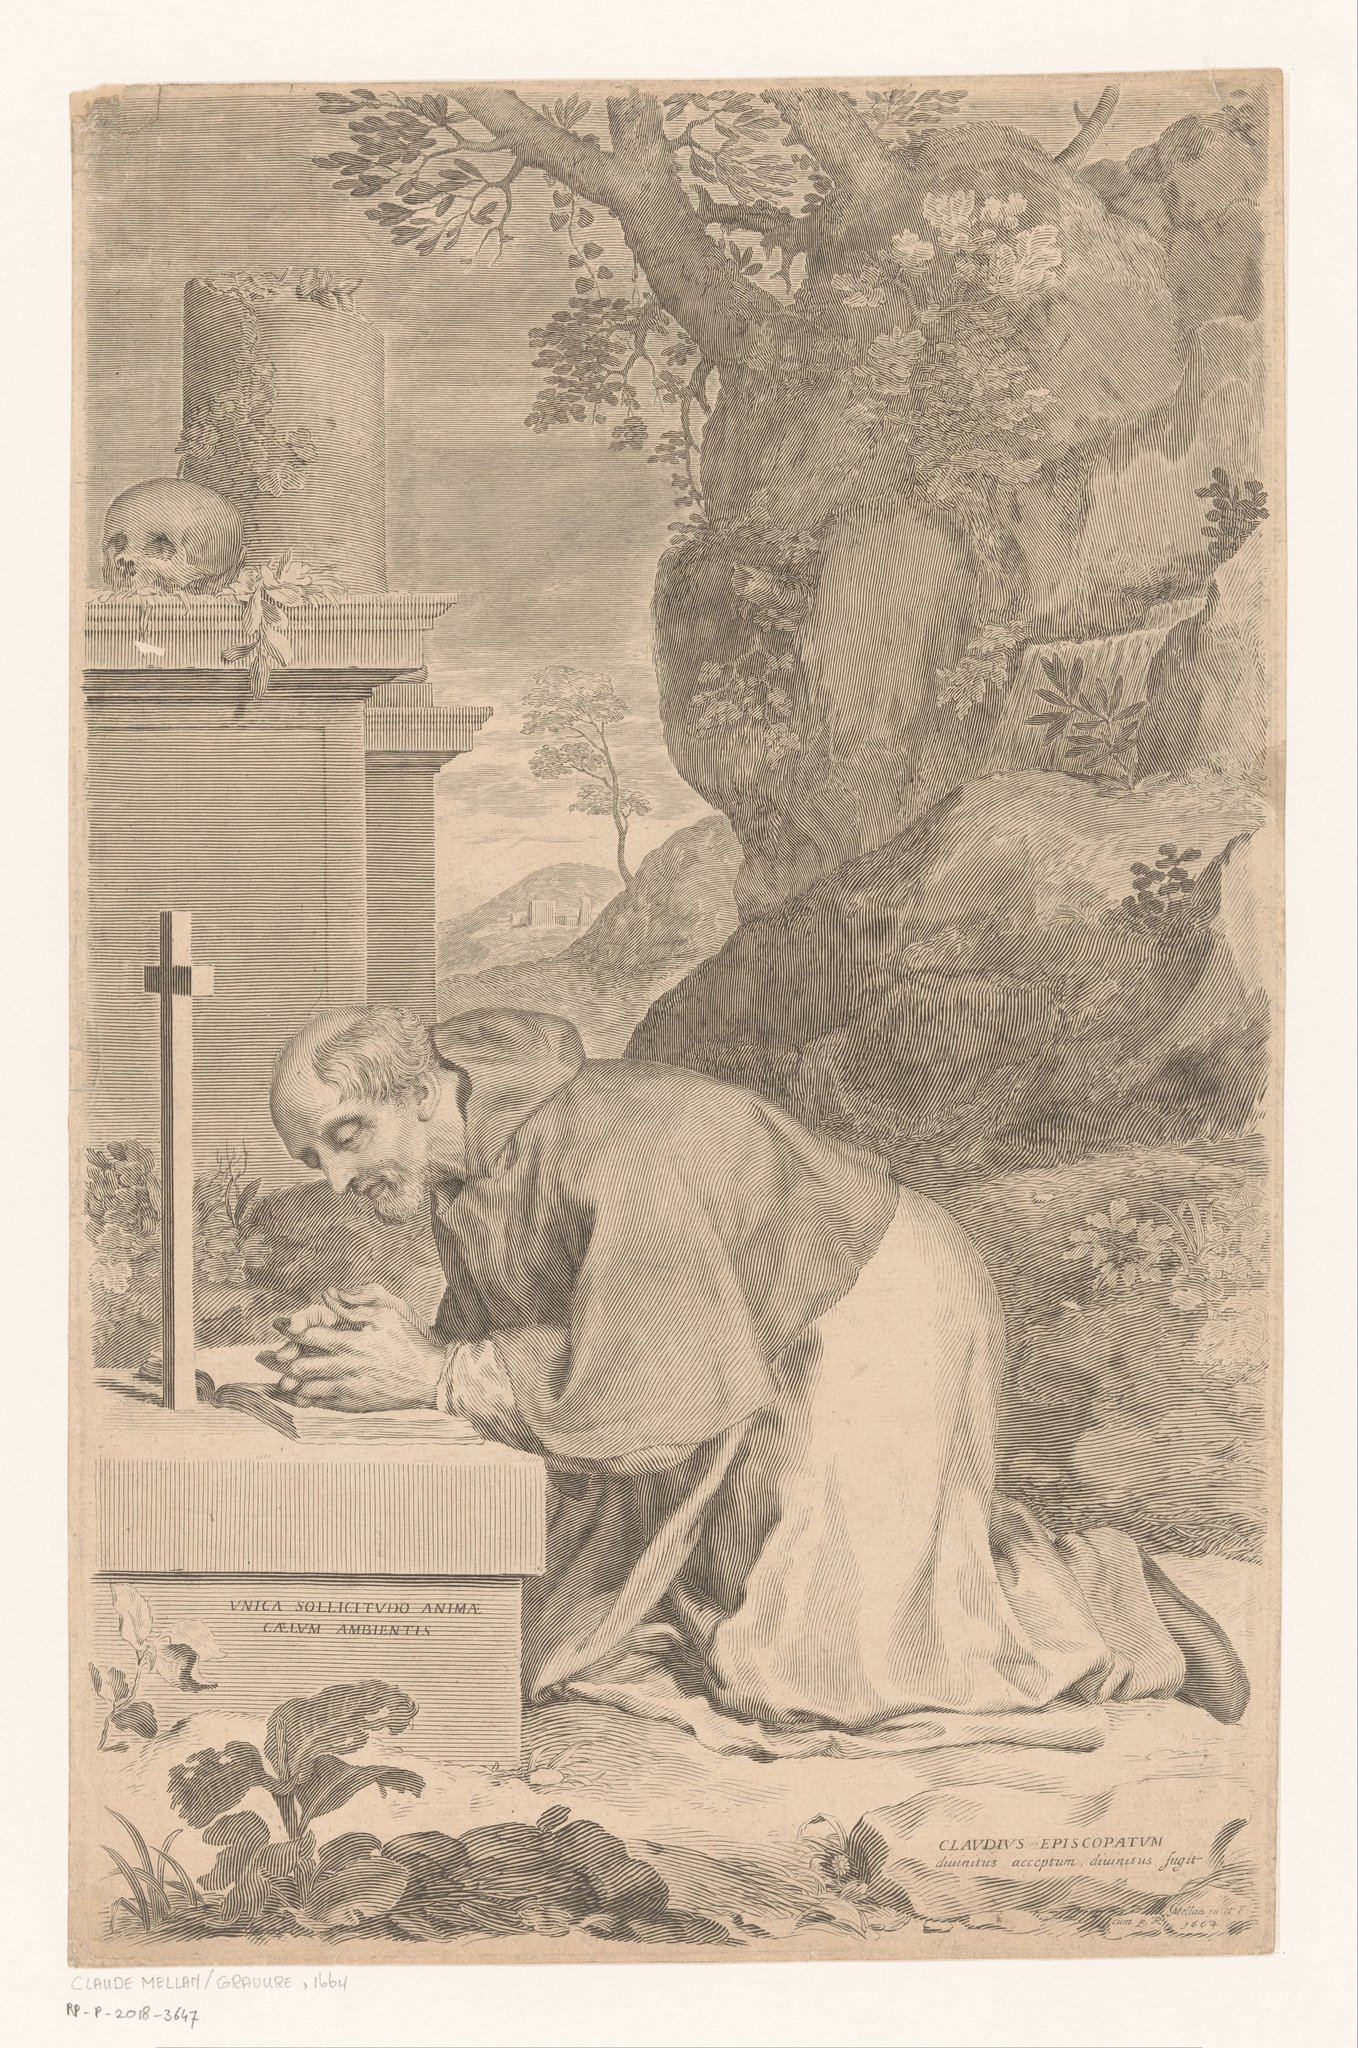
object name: print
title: H. Claudius in gebed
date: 1664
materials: paper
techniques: engraving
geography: france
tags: (human) skull, saints, one person praying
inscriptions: inscription: ‘presented to m[...] Rev.d R.G.P. Tiddeman M.A./ at Oxford Oct. 1853.’, collector's mark: Lugt 2228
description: Deze prent werd door Claude Guillois te Parijs gebruikt voor zijn thesis, zondag 29 juni 1670.